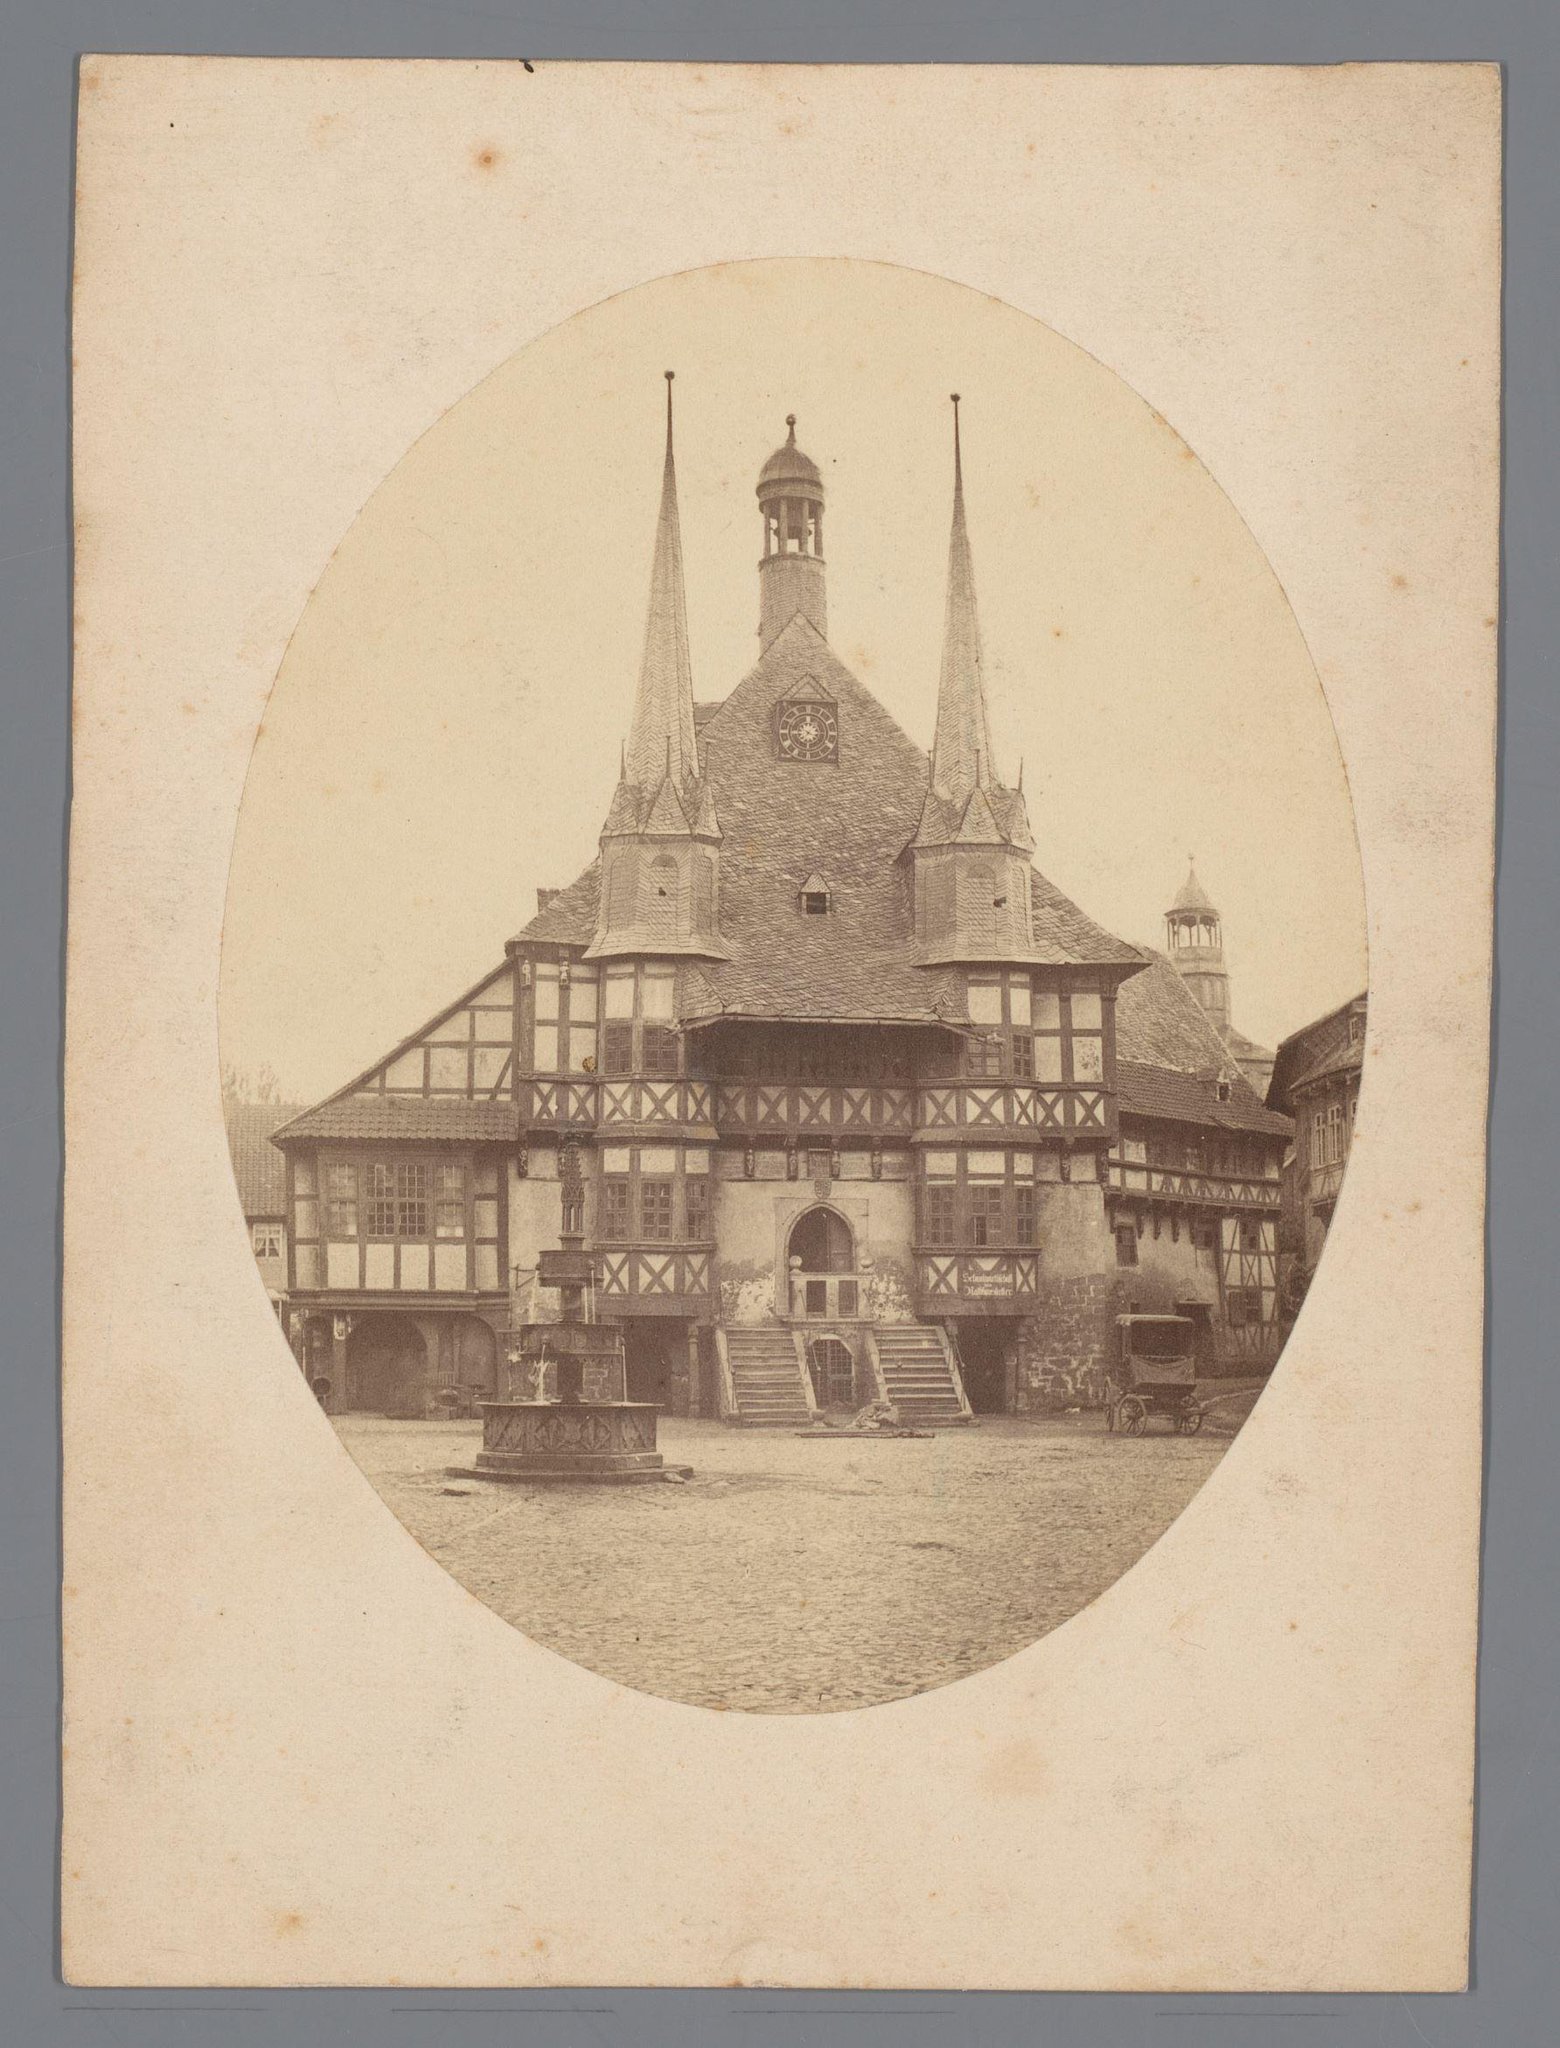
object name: photograph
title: Rathaus zu Wernigerode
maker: Anonymous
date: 1860-1890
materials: cardboard, paper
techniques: albumen print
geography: wernigerode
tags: townhall